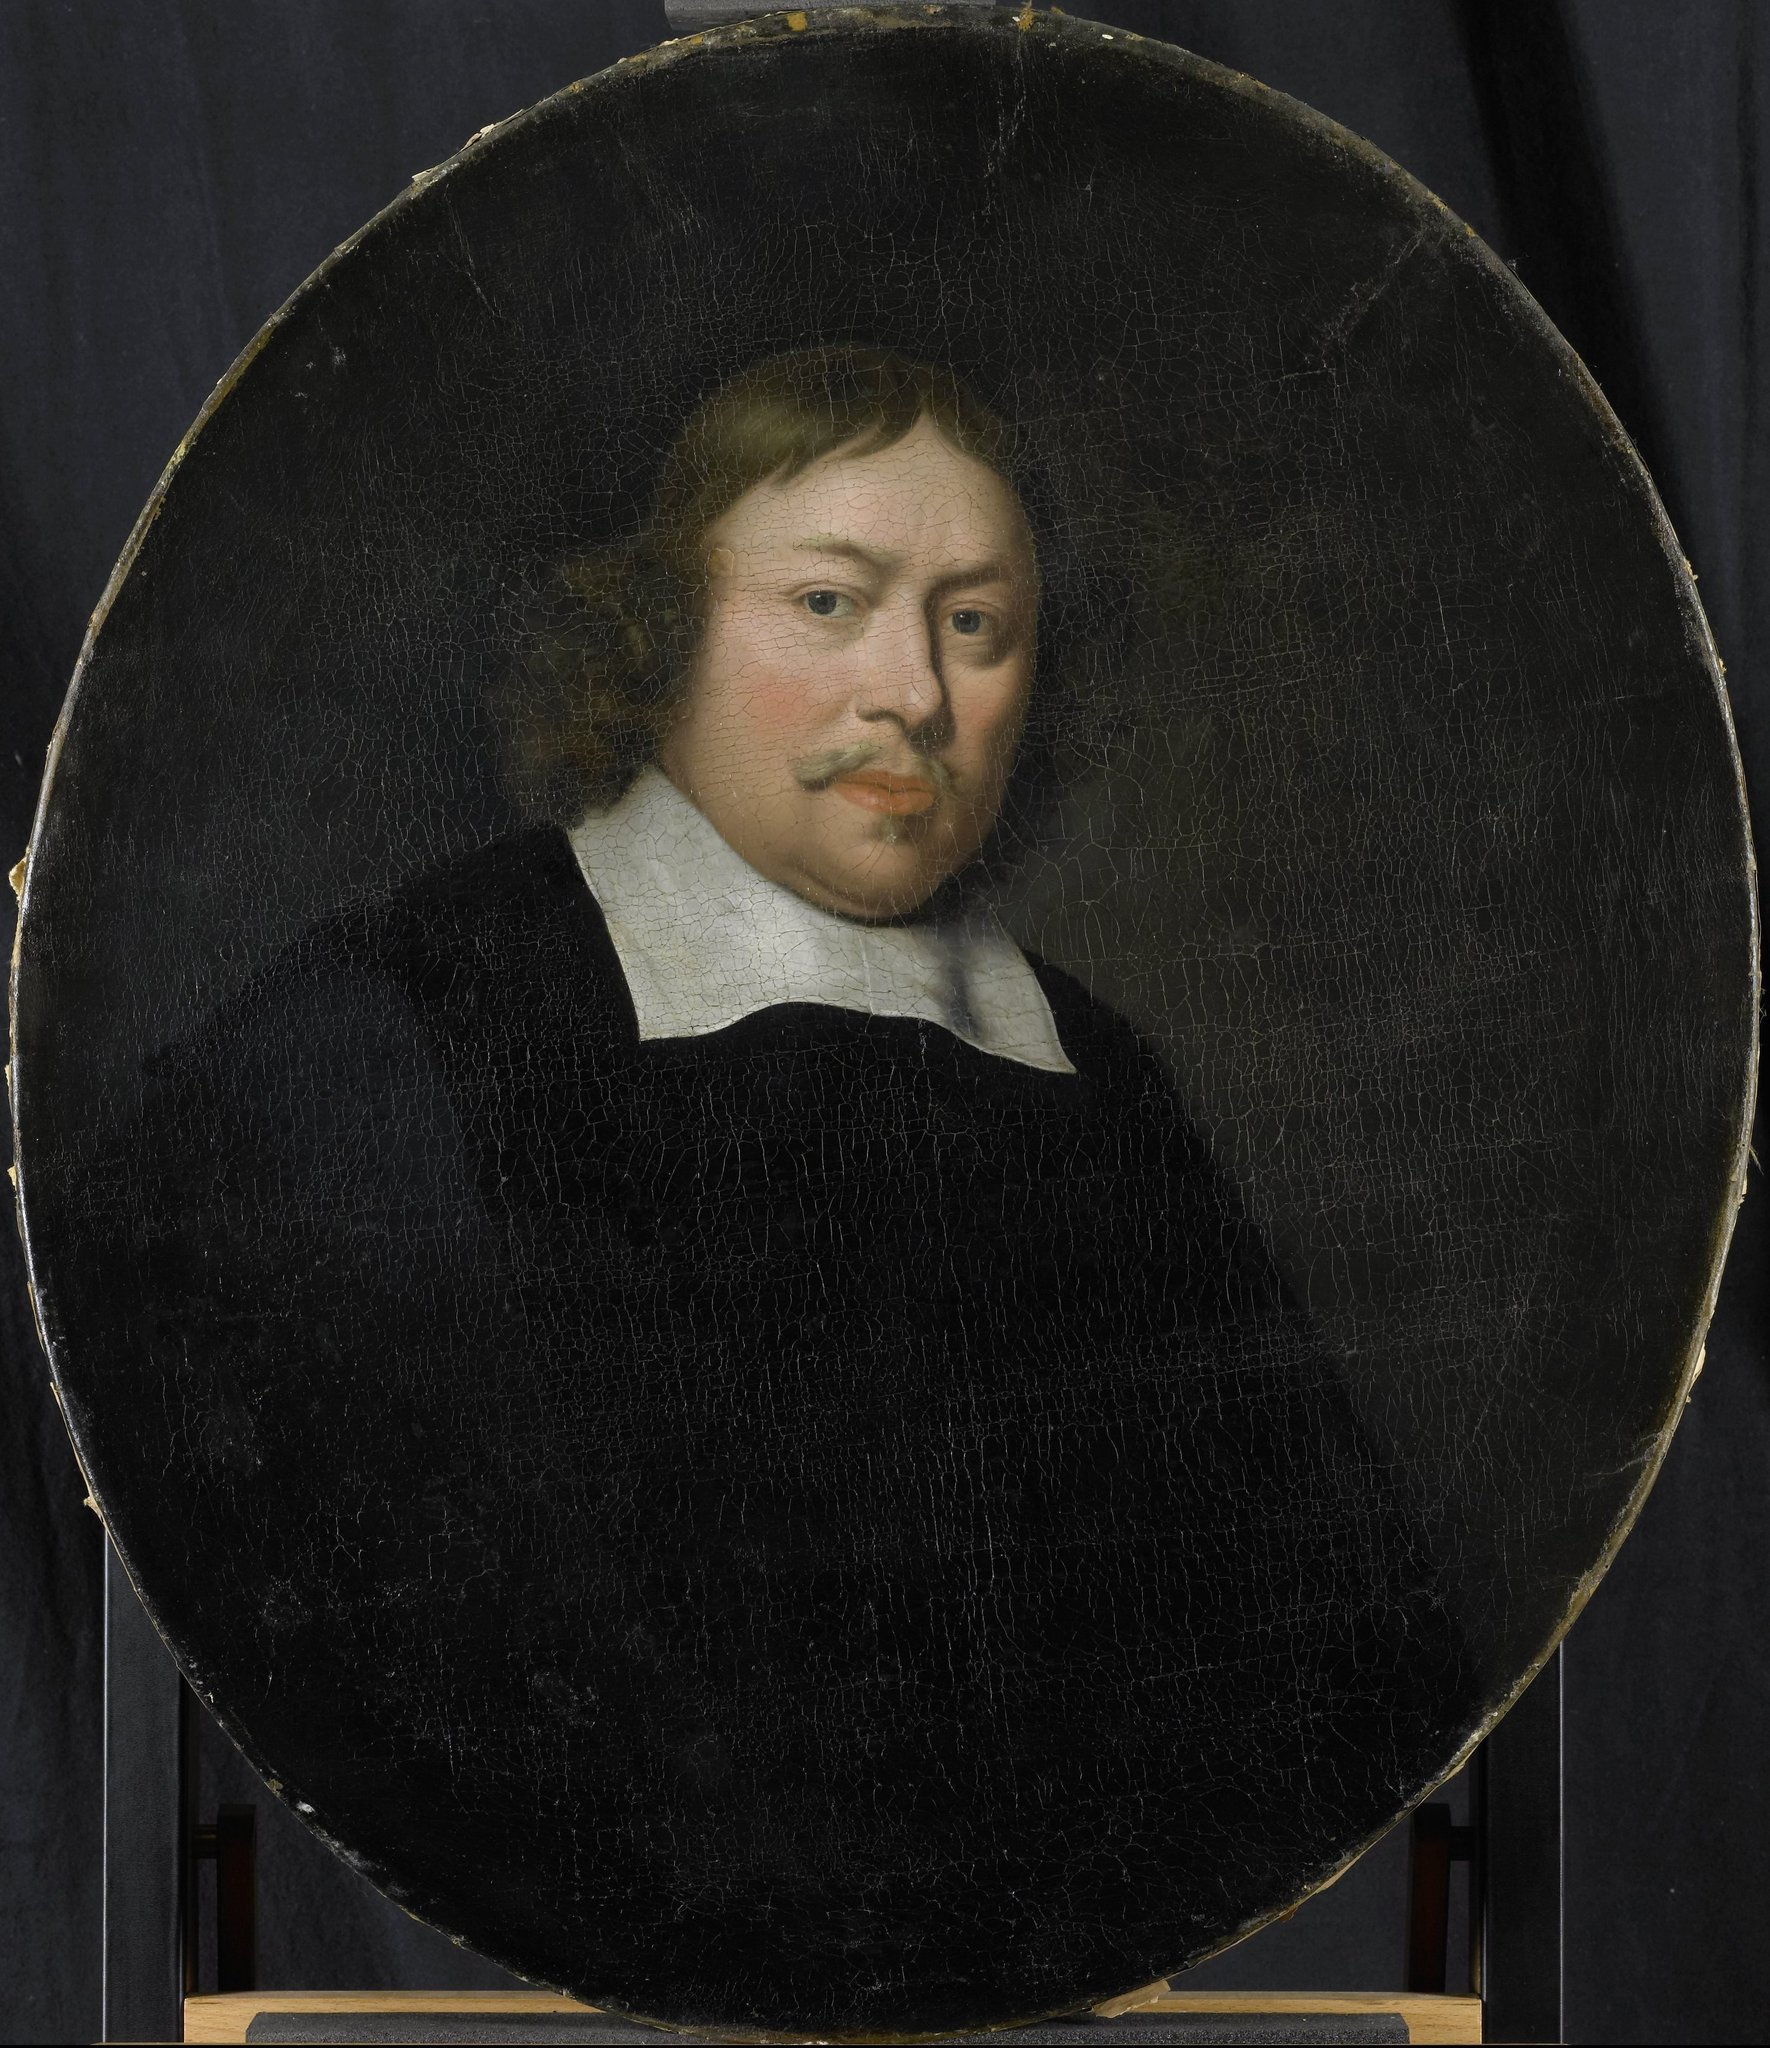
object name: painting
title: Portrait of Gerard van Bergen, Director of the Rotterdam Chamber of the Dutch East India Company, elected 1653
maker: pieter van der werff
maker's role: draughtsman, painter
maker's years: 1665-1722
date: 1695-1722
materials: canvas, oil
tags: rotterdam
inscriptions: inscription: ‘16 Gerard van Bergen. 53’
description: Portret van Gerard van Bergen (gest. 1663), gekozen in 1653. Buste in ovaal naar rechts. Onderdeel van een reeks portretten van de bewindhebbers van de Rotterdamse Kamer van de Verenigde Oost-Indische Compagnie, vervaardigd voor het Nieuw Oost-Indisch Huis uit 1698 aan de Boompjes te Rotterdam.